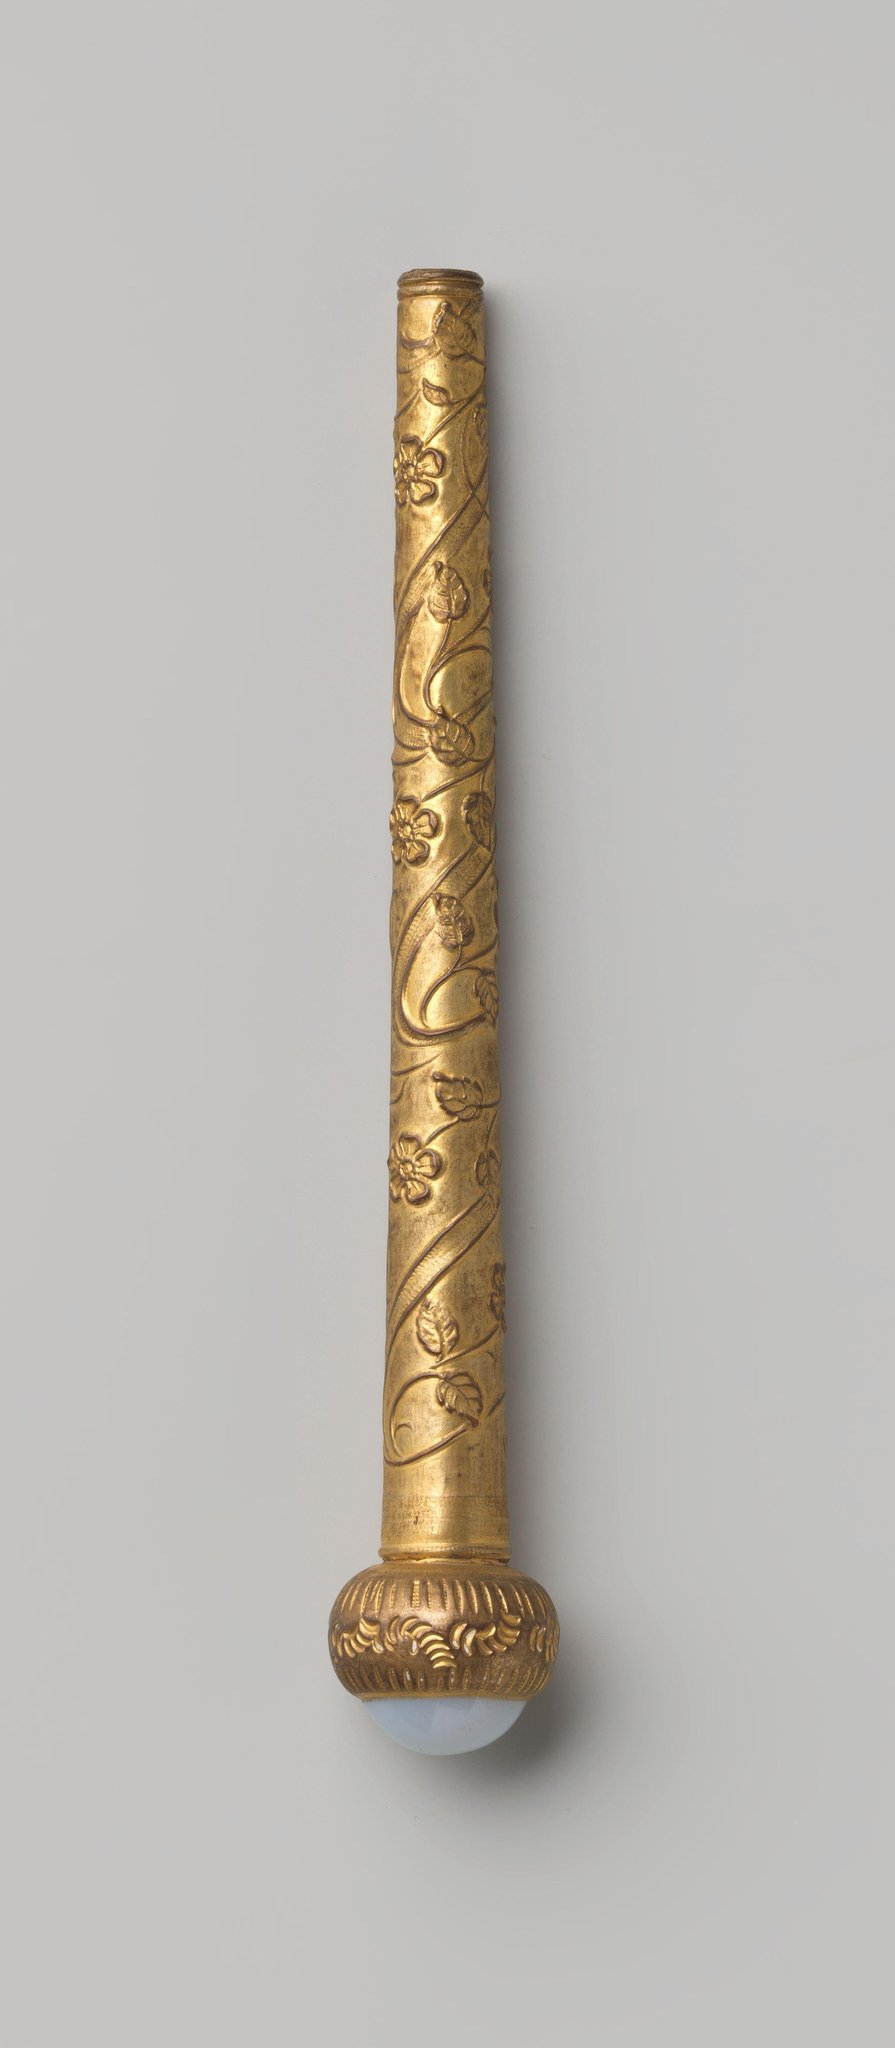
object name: handle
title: Konisch handvat en ronde knop van gedreven koper, voor een paraplu of parasol; met maansteen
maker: gustav schnitzler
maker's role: paraplufabrikant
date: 1910-1920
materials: copper, mineral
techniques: repoussé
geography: nijmegen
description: Konisch handvat en ronde knop van gedreven koper, voor een paraplu of parasol. De knop bestaat uit een in gedreven koper gevatte maansteen.